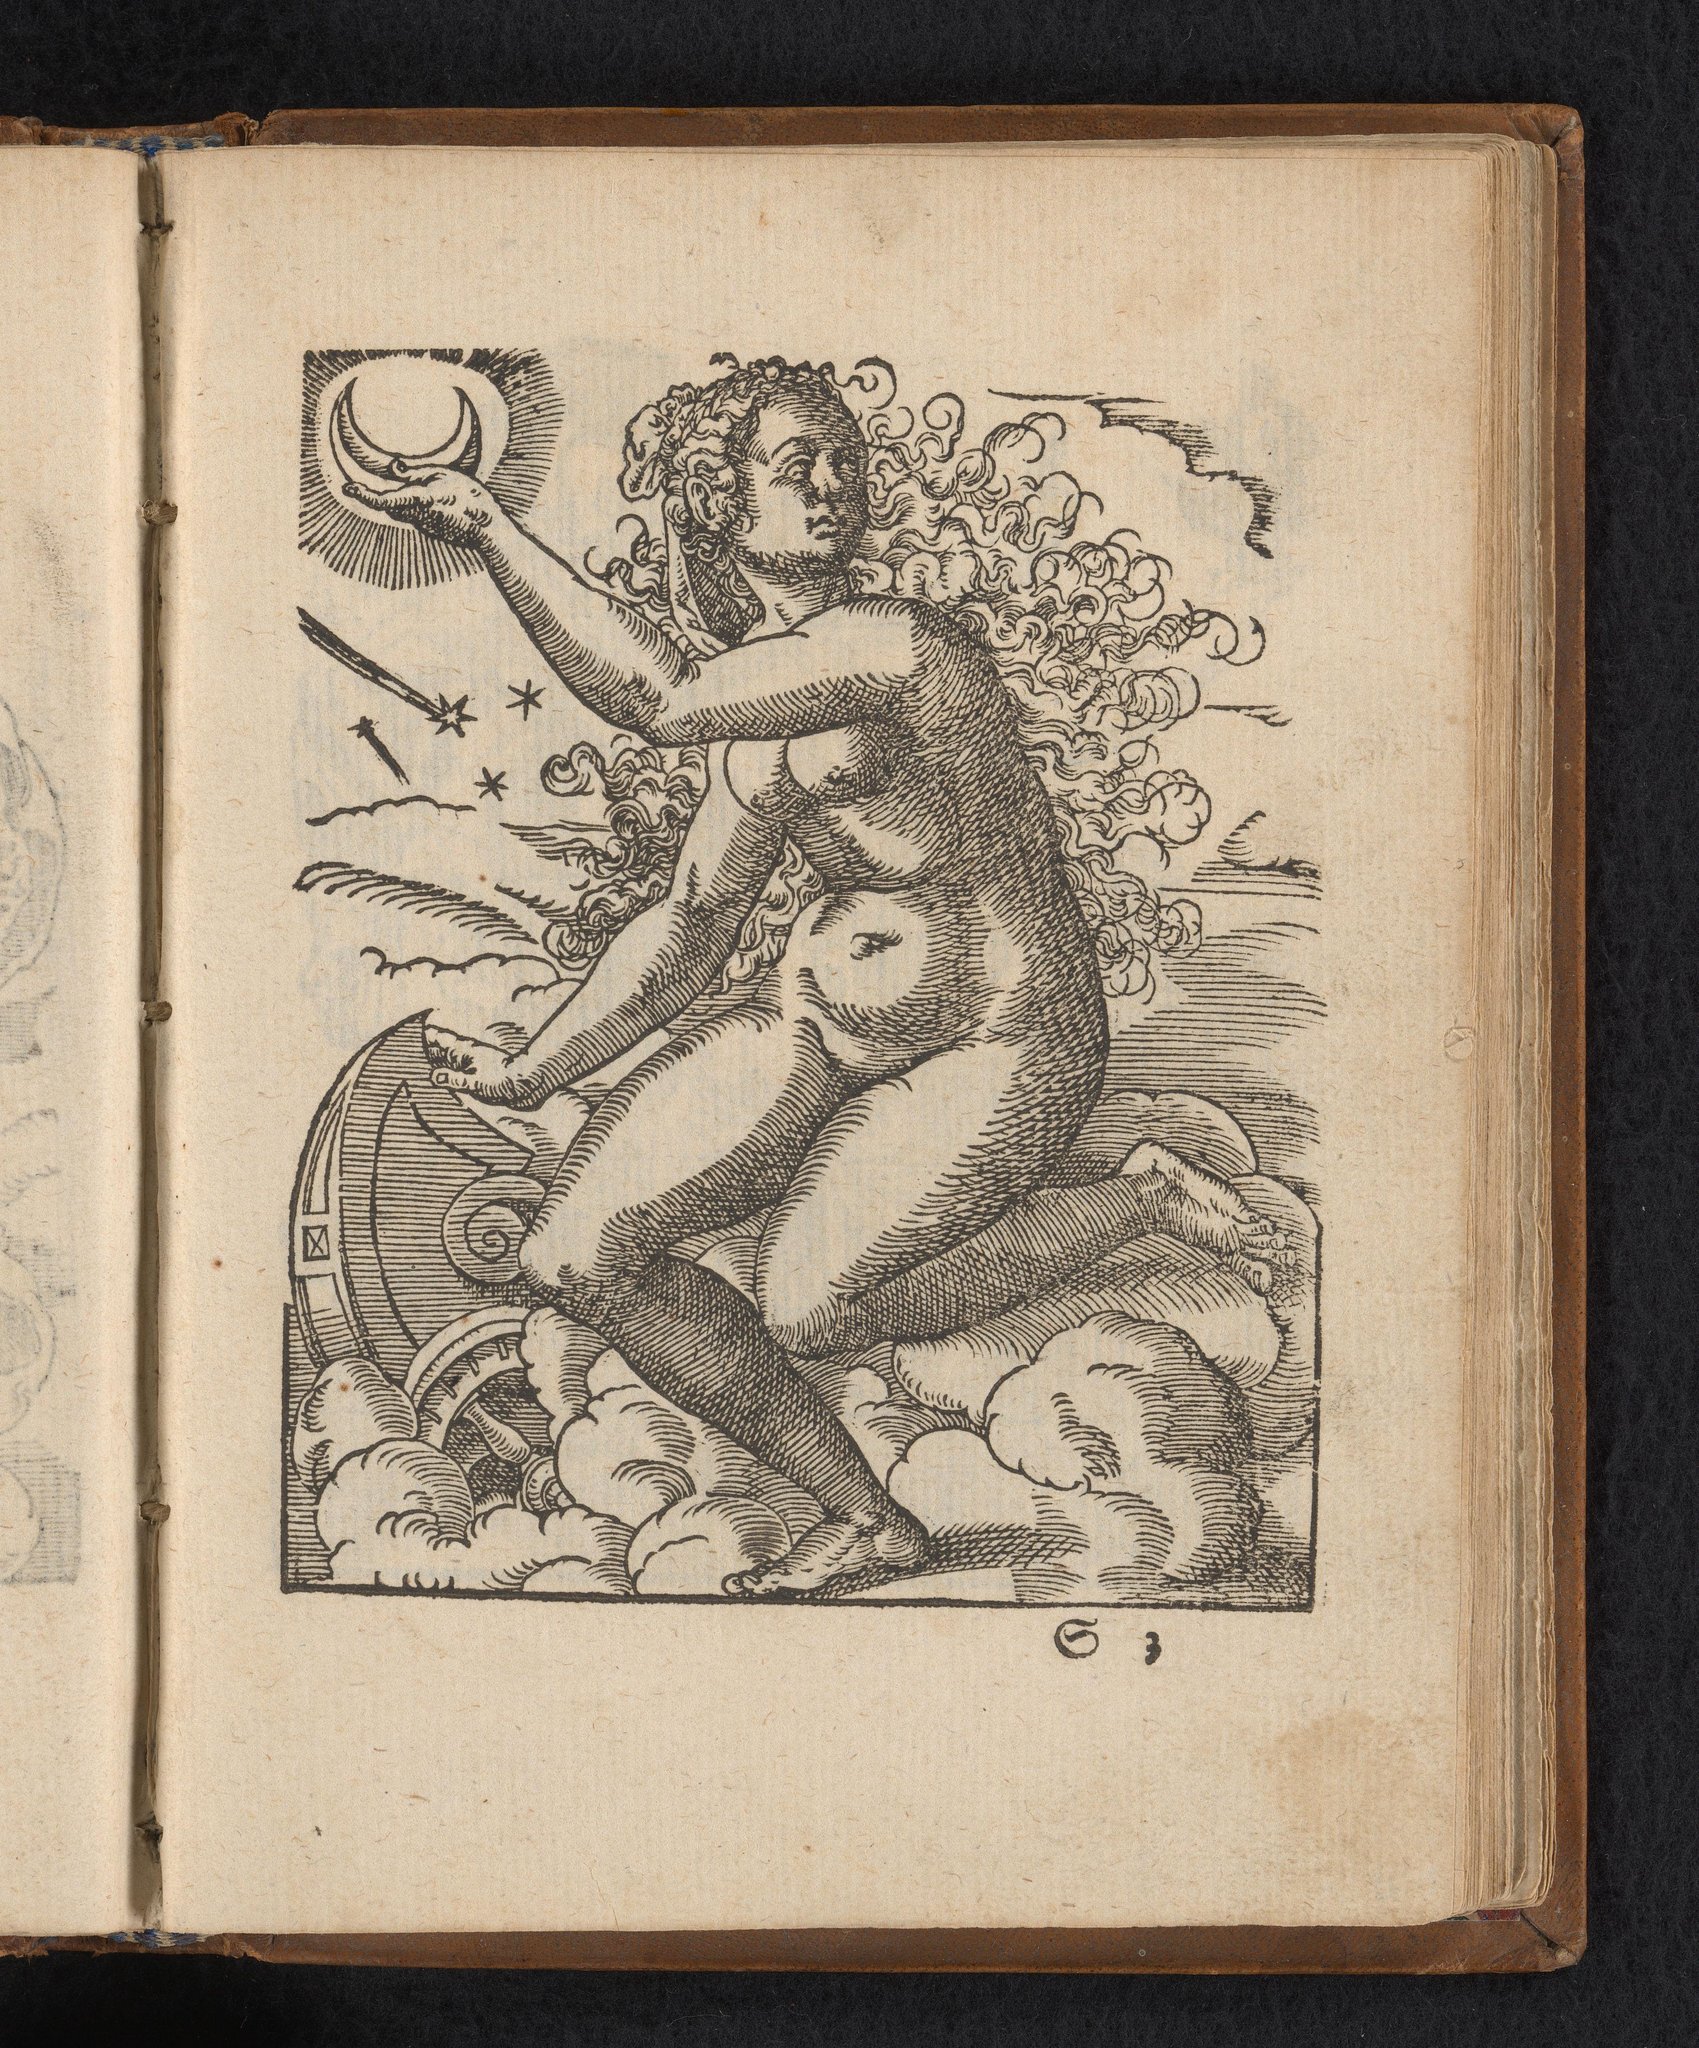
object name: print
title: Diana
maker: Anonymous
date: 1578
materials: paper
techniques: woodcut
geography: nuremberg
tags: diana as moon-goddess, i.e. luna (selene)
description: Diana als Luna in de wolken, de maansikkel in de hand. Onderdeel van het modelboek Enchiridion artis pingendi, fingendi & sculpendi met 108 figuren bedoeld voor beginnende schilders, beeldhouwers en prentmakers.